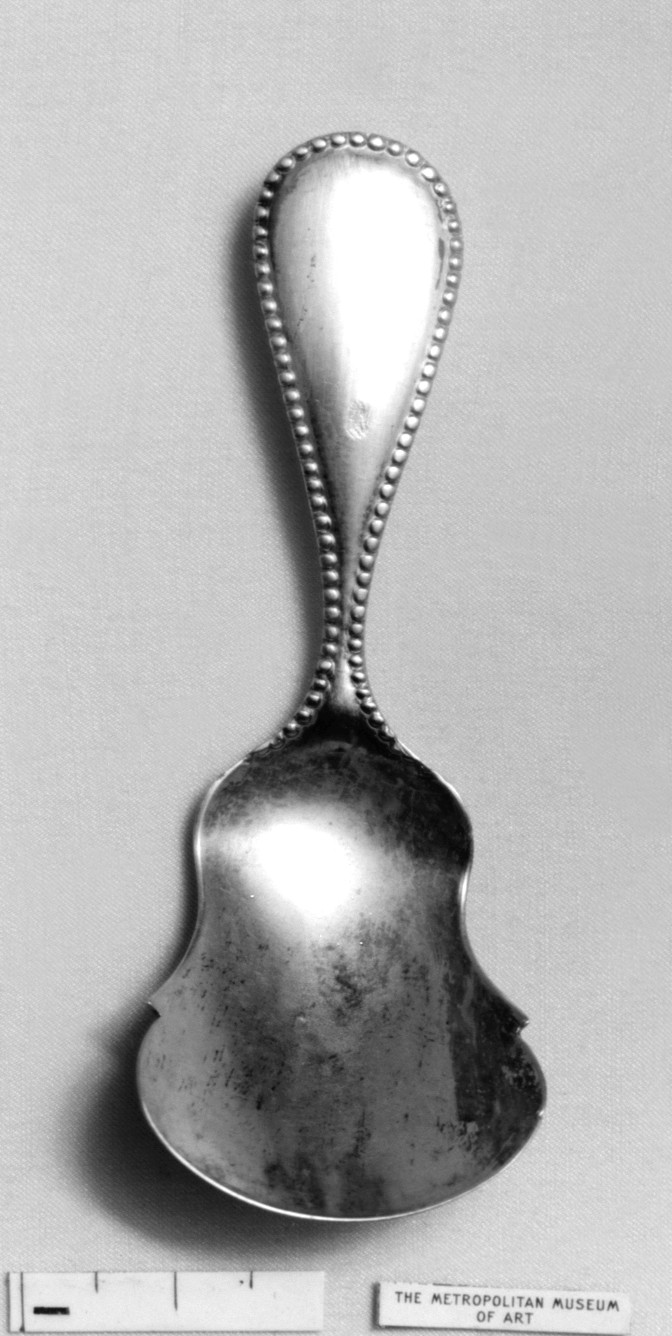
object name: caddy spoon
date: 1801-1833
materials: silver